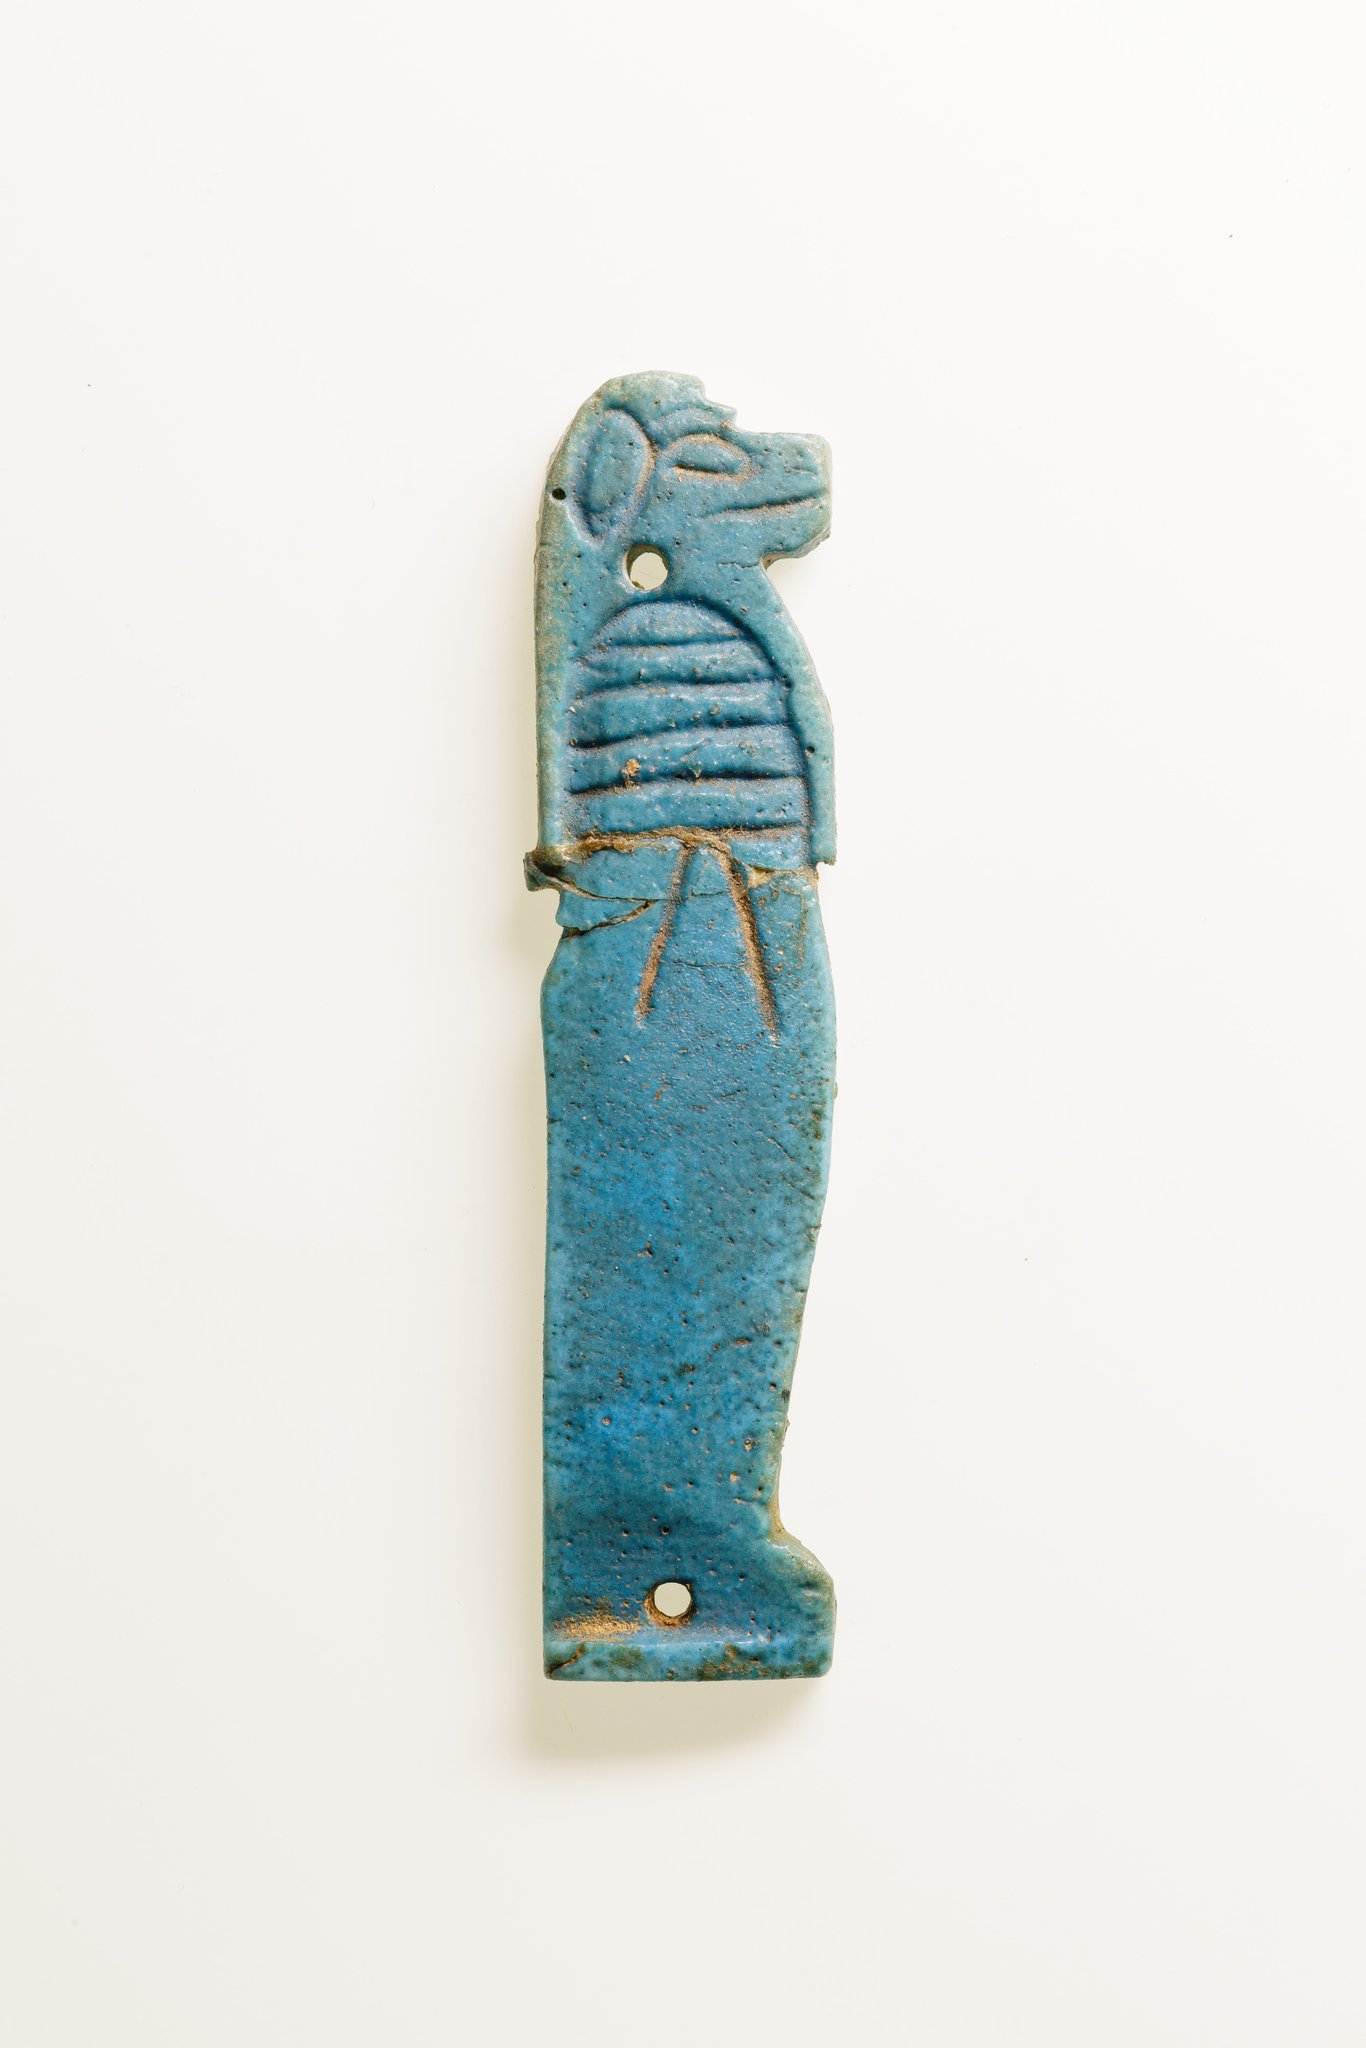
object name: amulet, son of horus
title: Son of Horus (Hapy) from Bead Net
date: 1070-525 BCE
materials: faience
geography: egypt